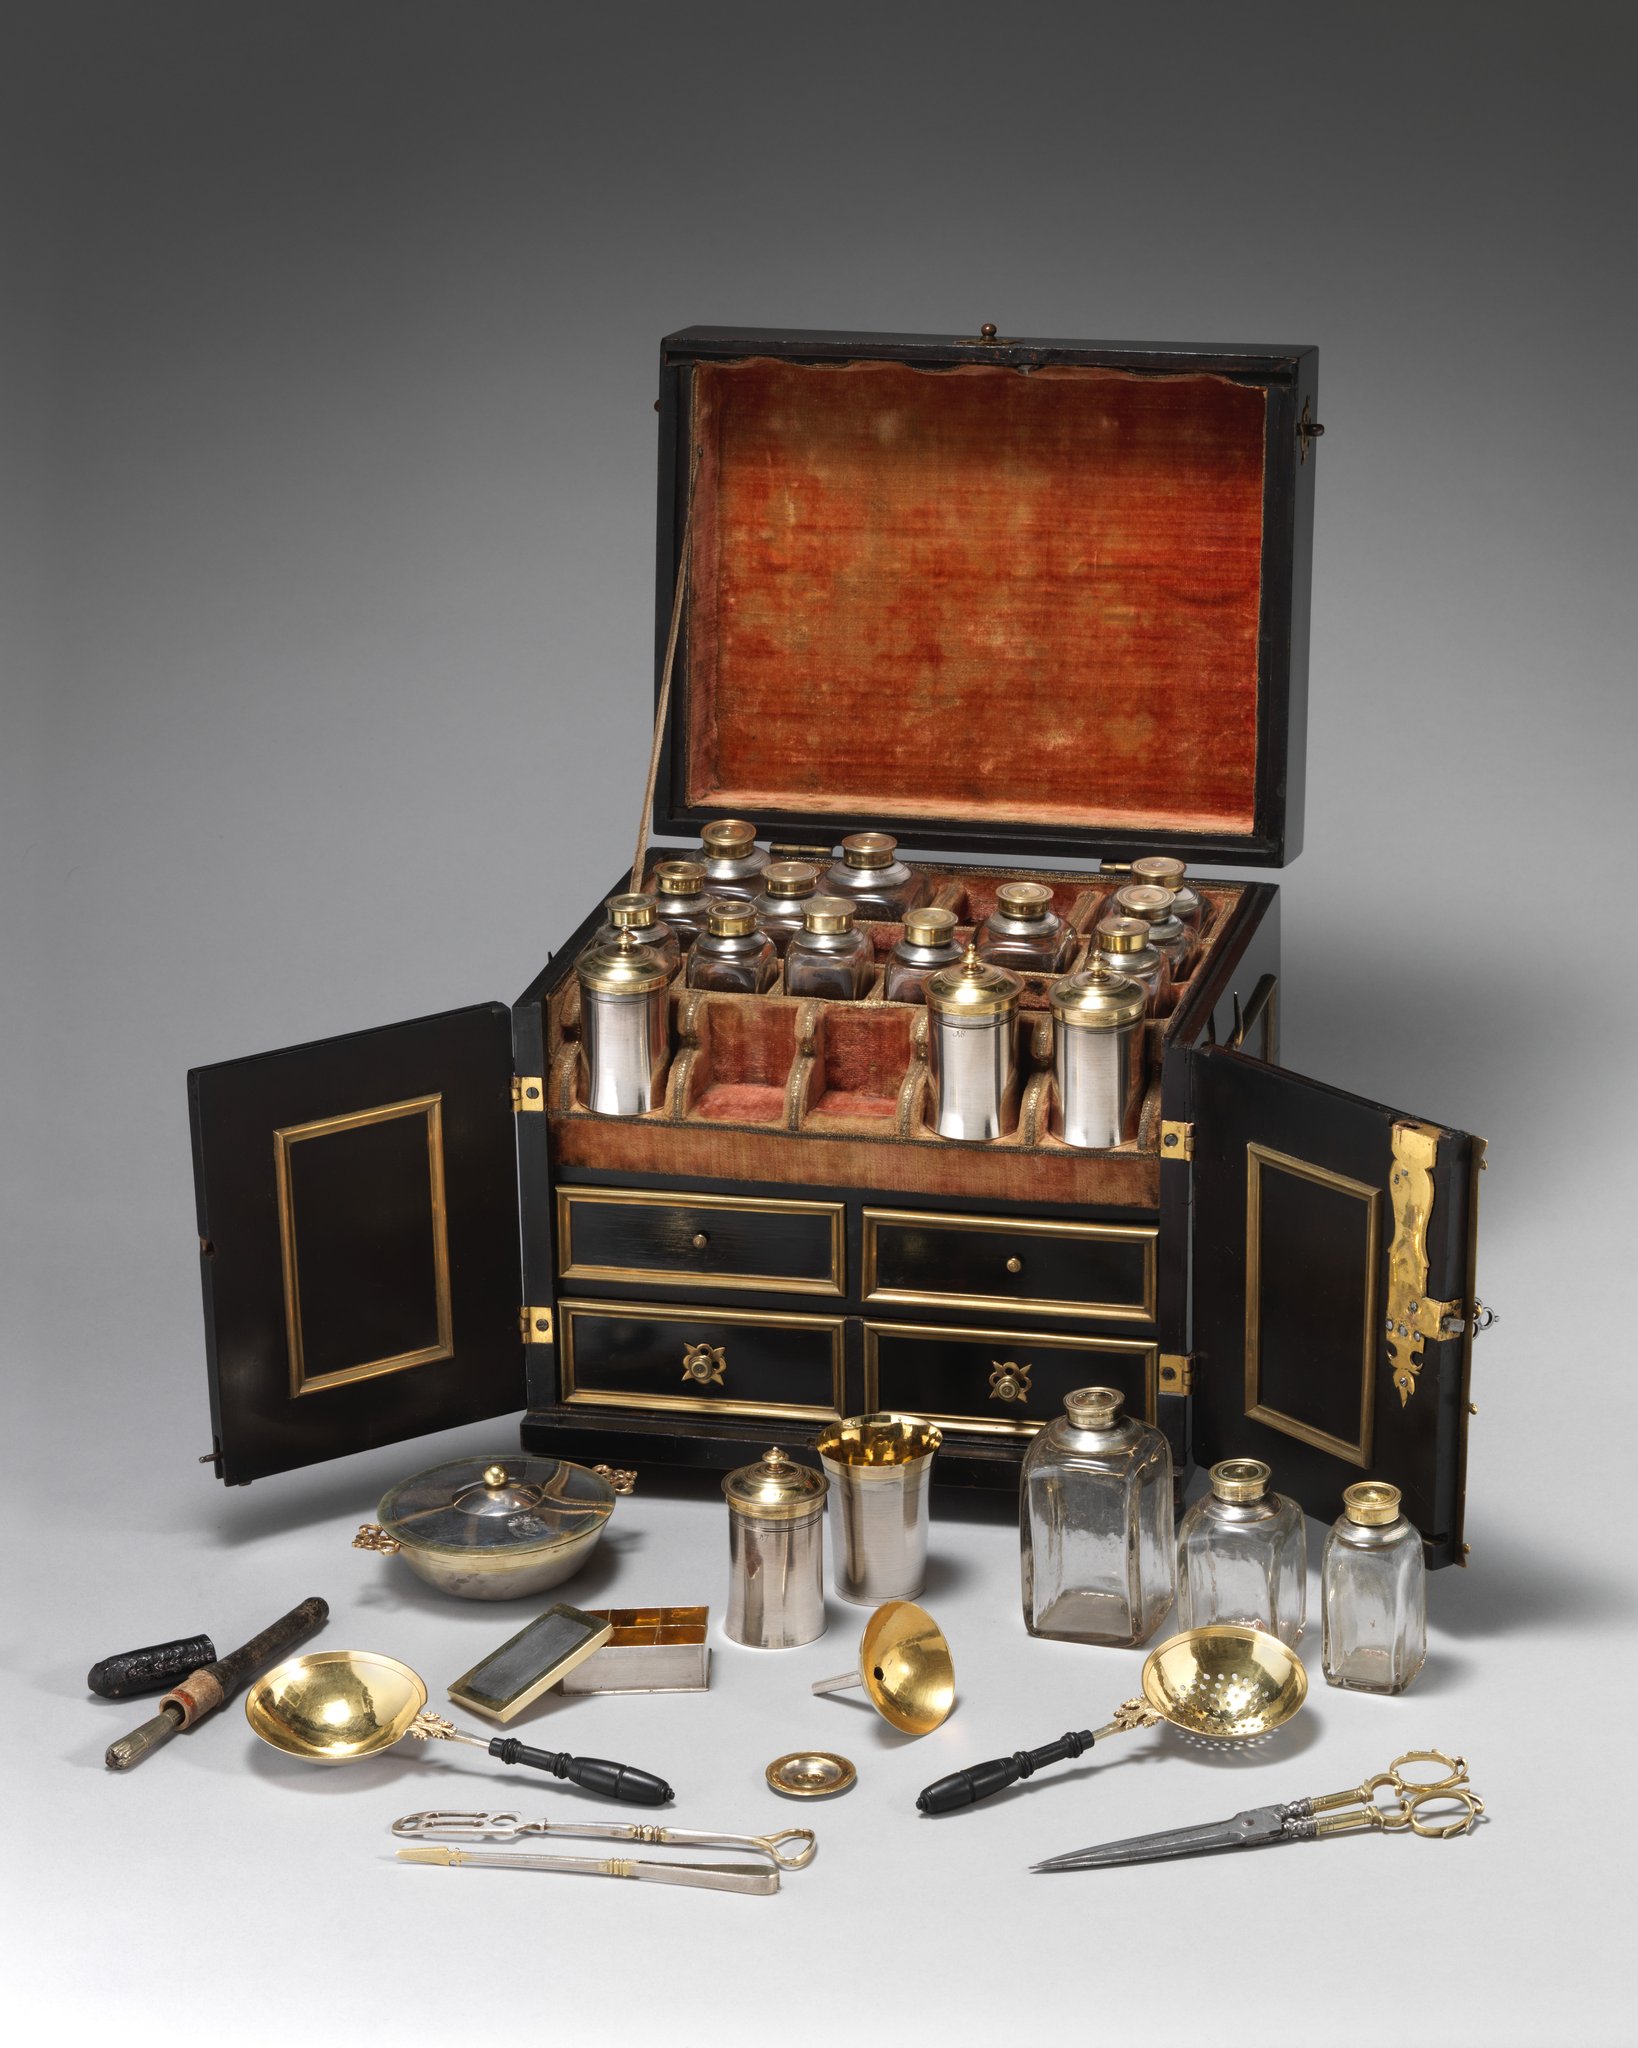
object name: apothecary cabinet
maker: nicolaus i kolb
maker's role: goldsmith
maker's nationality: german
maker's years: 1550-1621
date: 1617-1618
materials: wood, gilt brass, gilt silver, glass, gold, leather, silk, steel, velvet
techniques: veneering